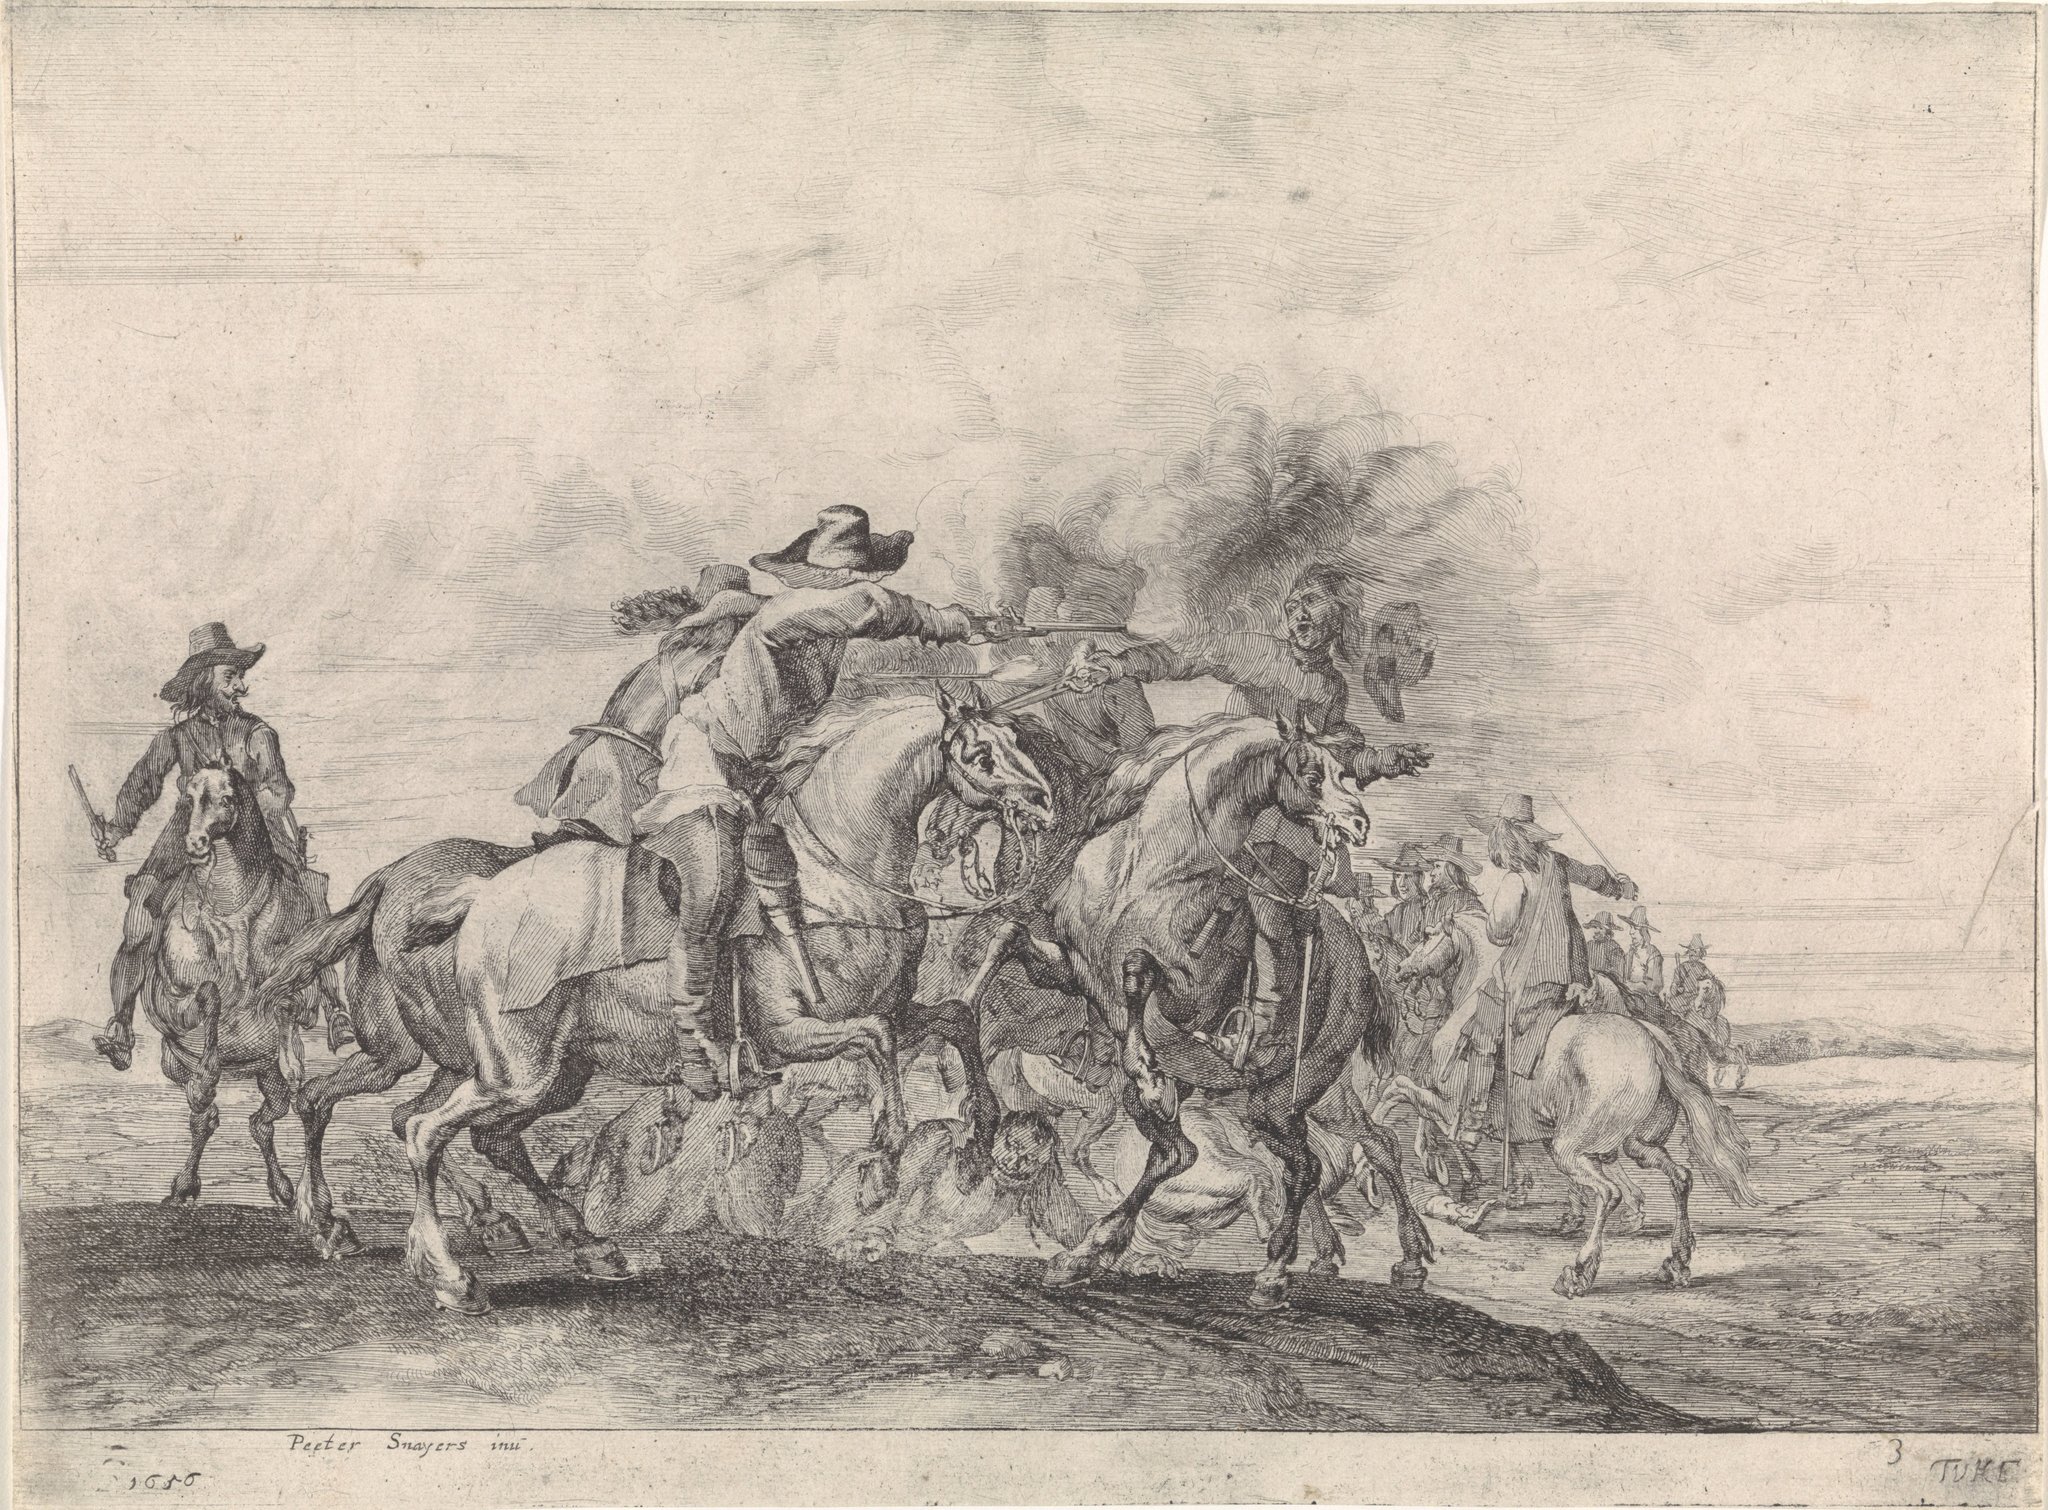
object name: print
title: Slagveld met cavalerie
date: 1656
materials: paper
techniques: etching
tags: battle (+ cavalry, horsemen)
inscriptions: collector's mark: Lugt 240, inscription: ‘TVKF 3’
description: Slagveld met op de voorgrond twee ruiters die van dichtbij op de hoofden van twee andere ruiters schieten, terwijl hun paarden steigeren. Op de grond kruipt een soldaat die van zijn paard gevallen is. Deze prent maakt deel uit van een zesdelige serie over cavalerie gevechten.